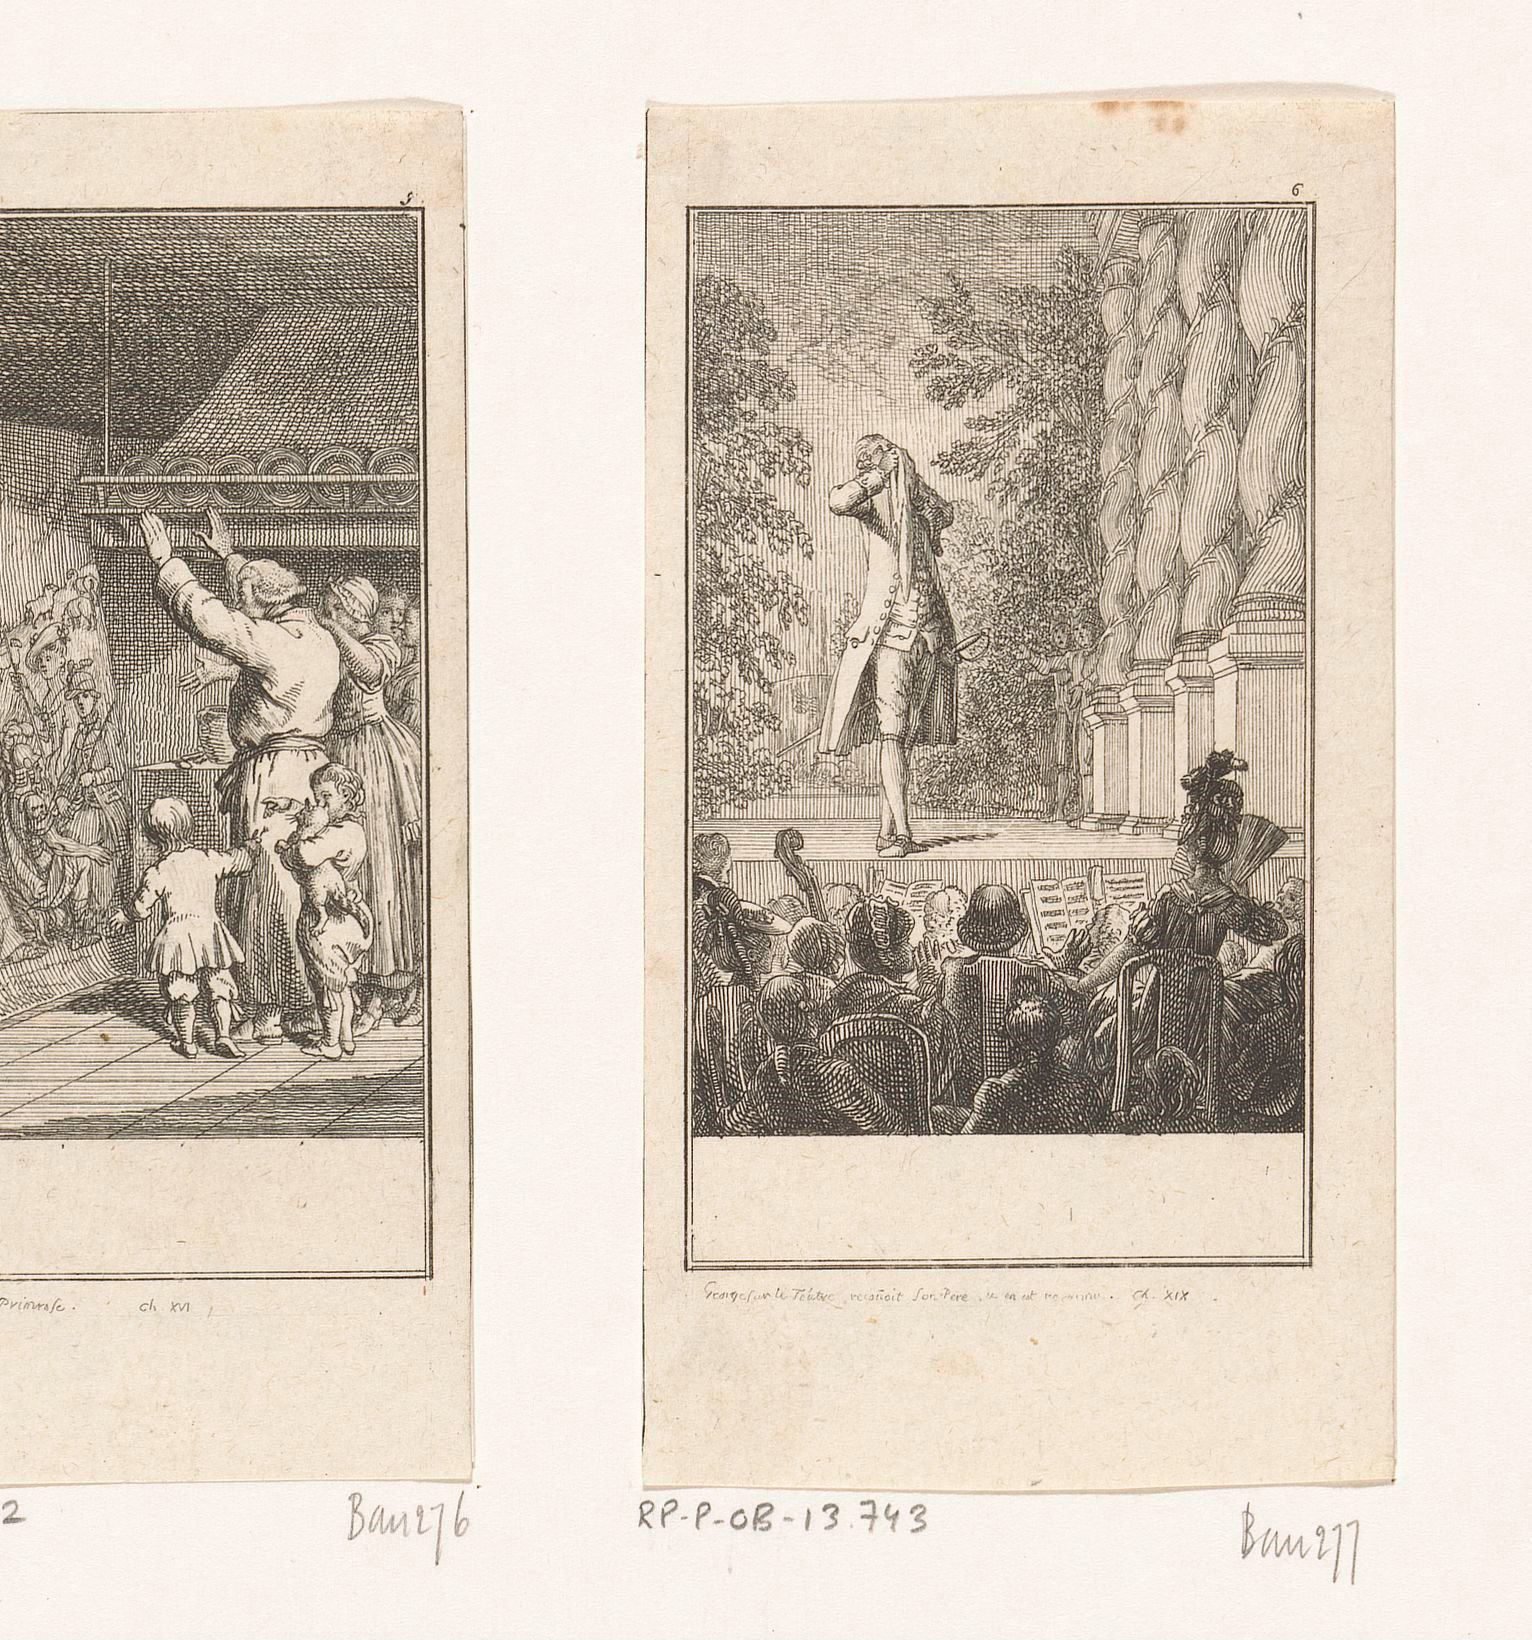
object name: print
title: George herkent zijn vader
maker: daniel nikolaus chodowiecki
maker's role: draughtsman, print maker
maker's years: 1726-1801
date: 1776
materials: paper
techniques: etching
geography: berlin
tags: london, oliver goldsmith, theatre, theatrical performance, (goldsmith, the vicar of wakefield) specific works of literature (with author, title), weeping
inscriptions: collector's mark: Lugt 2228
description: Charles Primrose bezoekt bij toeval een voorstelling van een reizend theatergezelschap. De acteur op het toneel blijkt zijn zoon George. Charles heeft zijn familie al drie jaar niet gezien en barst in huilen uit als hij zijn vader en zijn voormalige verloofde Arabella herkent op de eerste rij. Rechtsboven genummerd: 6.